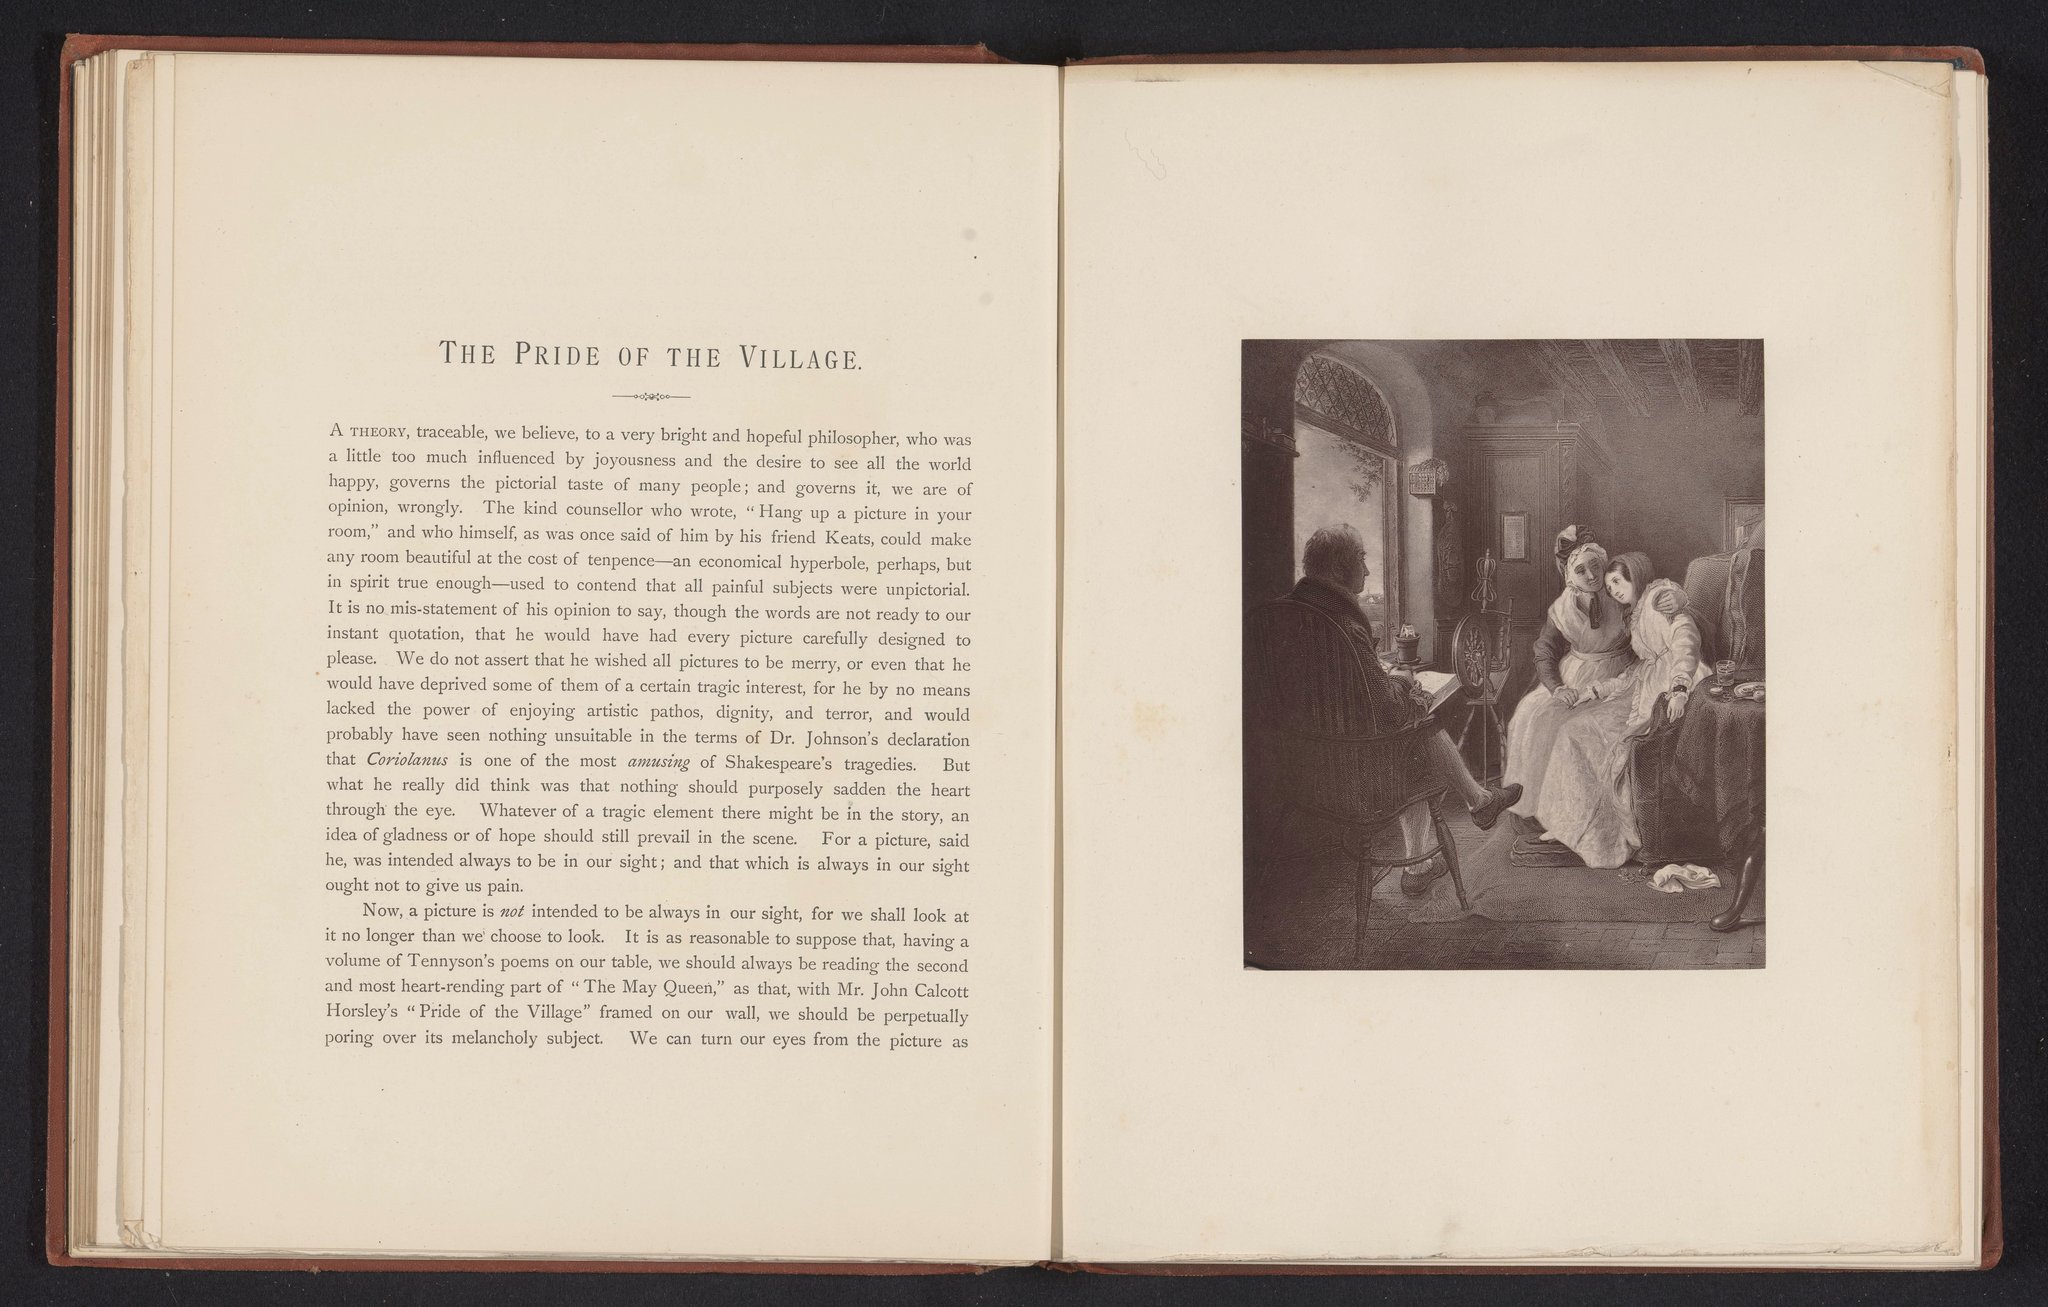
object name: reproduction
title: Fotoreproductie van een prent naar een schilderij, voorstellende ouders met hun dochter in een interieur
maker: Anonymous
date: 1861-1871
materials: paper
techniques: woodburytype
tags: parents with their children, church (exterior)